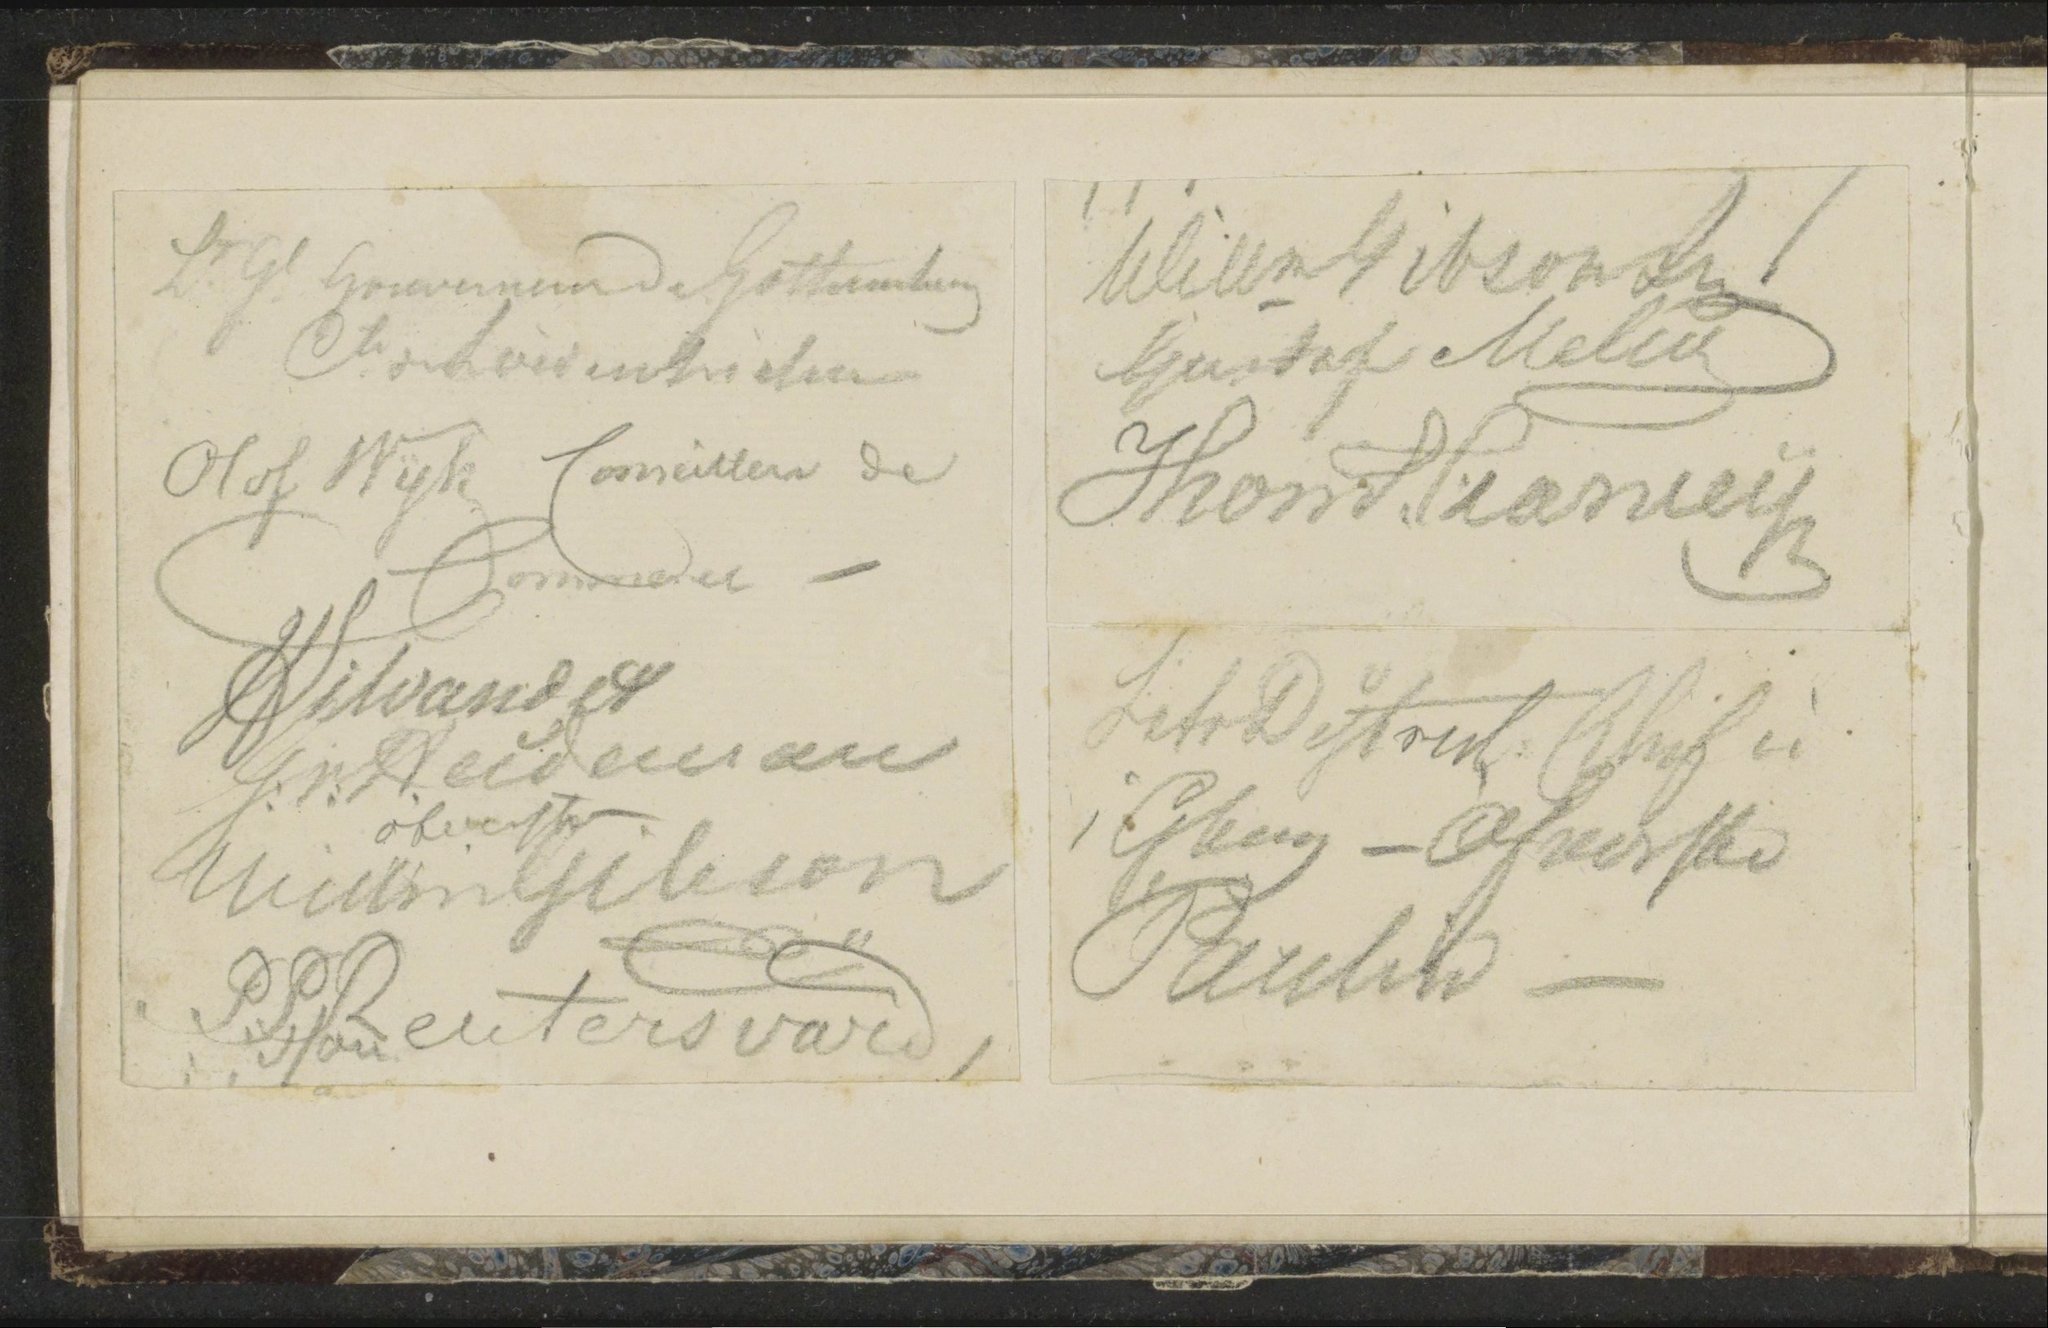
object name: sketchbook leaf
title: Namen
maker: christian heinrich gottlieb steuerwald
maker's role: draughtsman, print maker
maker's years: 1802-1874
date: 1845-1848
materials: paper, pencil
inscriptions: annotation: ‘L.G. Gouverneur de Gottenburg/ ...’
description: Blad 4 verso uit een schetsboek met 61 bladen.